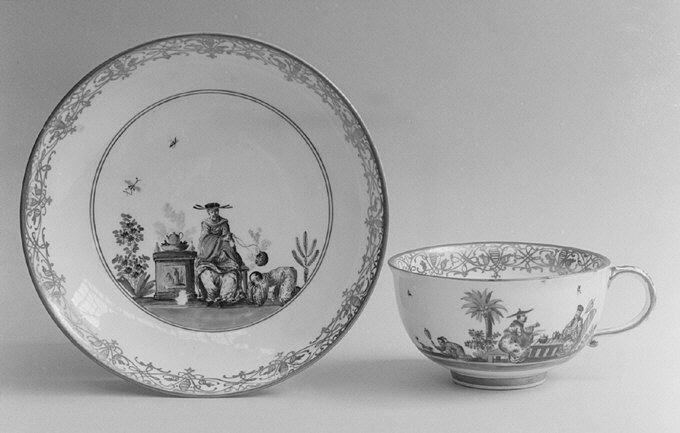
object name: saucer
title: Saucer (part of a set)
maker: meissen manufactory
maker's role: manufactory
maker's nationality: german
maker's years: 1710-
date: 1735-1740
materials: hard paste porcelain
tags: birds,men,insects